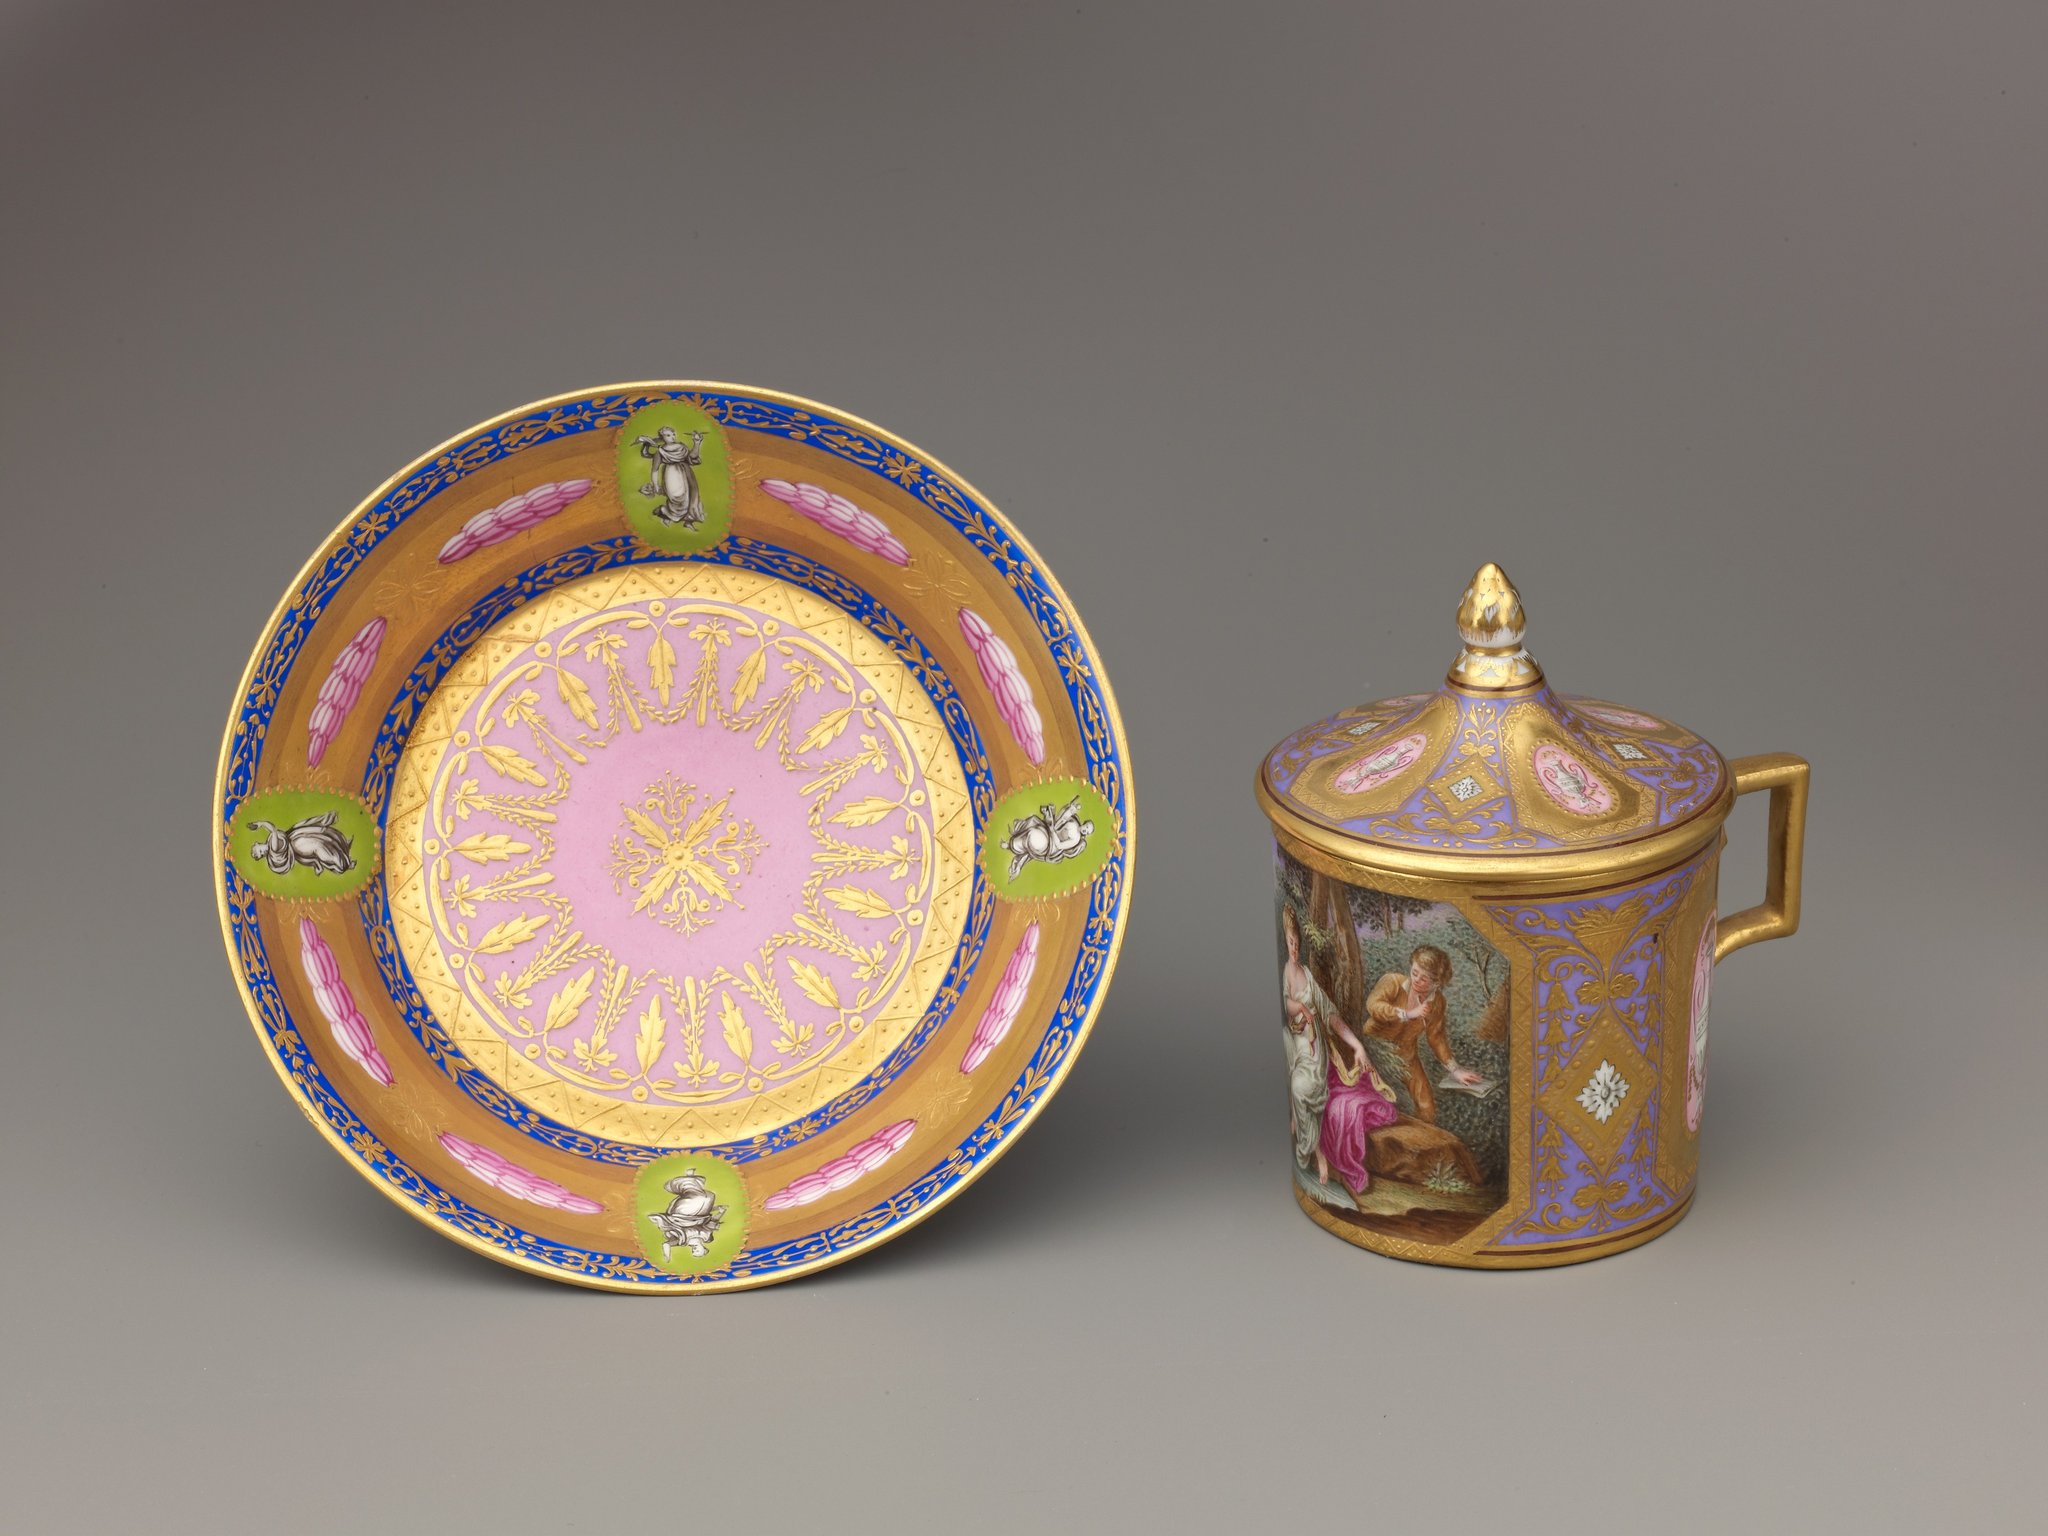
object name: covered cup and saucer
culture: austrian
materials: hard paste porcelain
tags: men,women